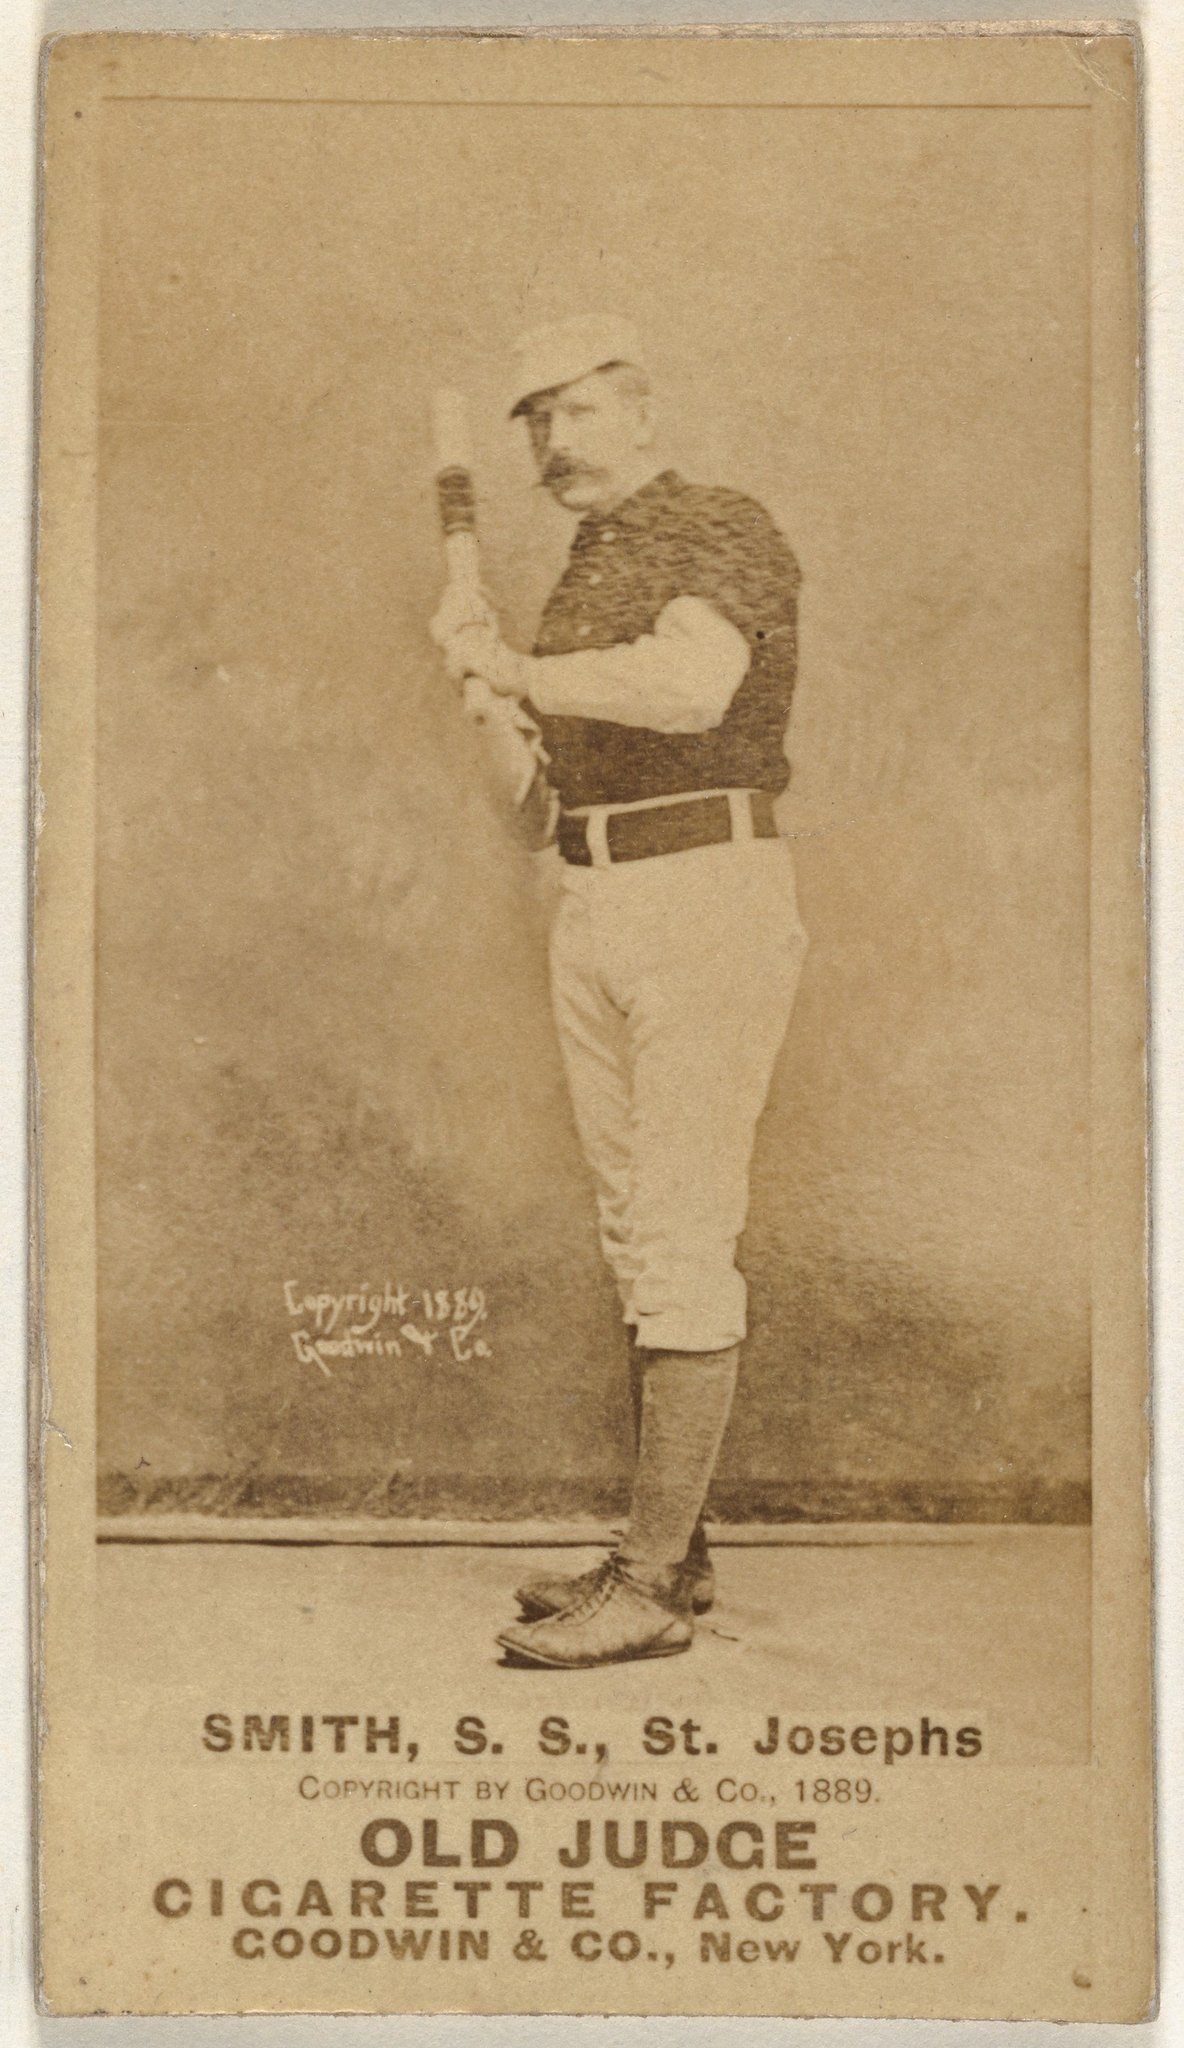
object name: baseball card, photograph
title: H. Smith, Shortstop, St. Joseph Clay Eaters, from the Old Judge series (N172) for Old Judge Cigarettes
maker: goodwin & company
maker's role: publisher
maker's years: 1850-1950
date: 1889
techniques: albumen silver print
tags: men,portraits,baseball,athletes